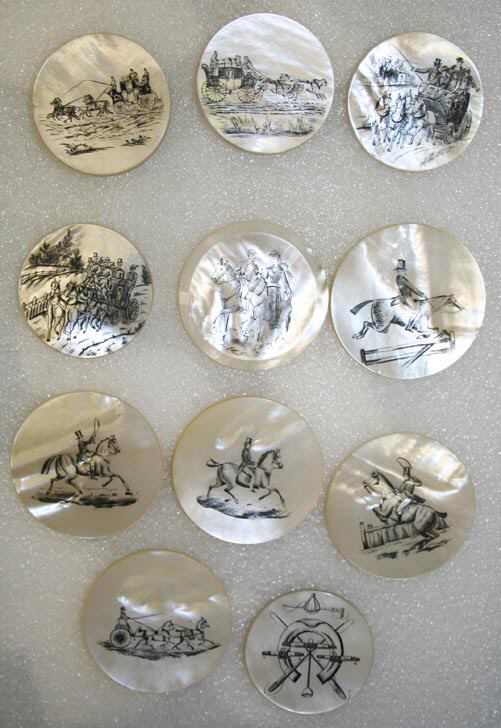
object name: button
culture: british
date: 1820-1850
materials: mother of pearl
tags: men,horses,carriages